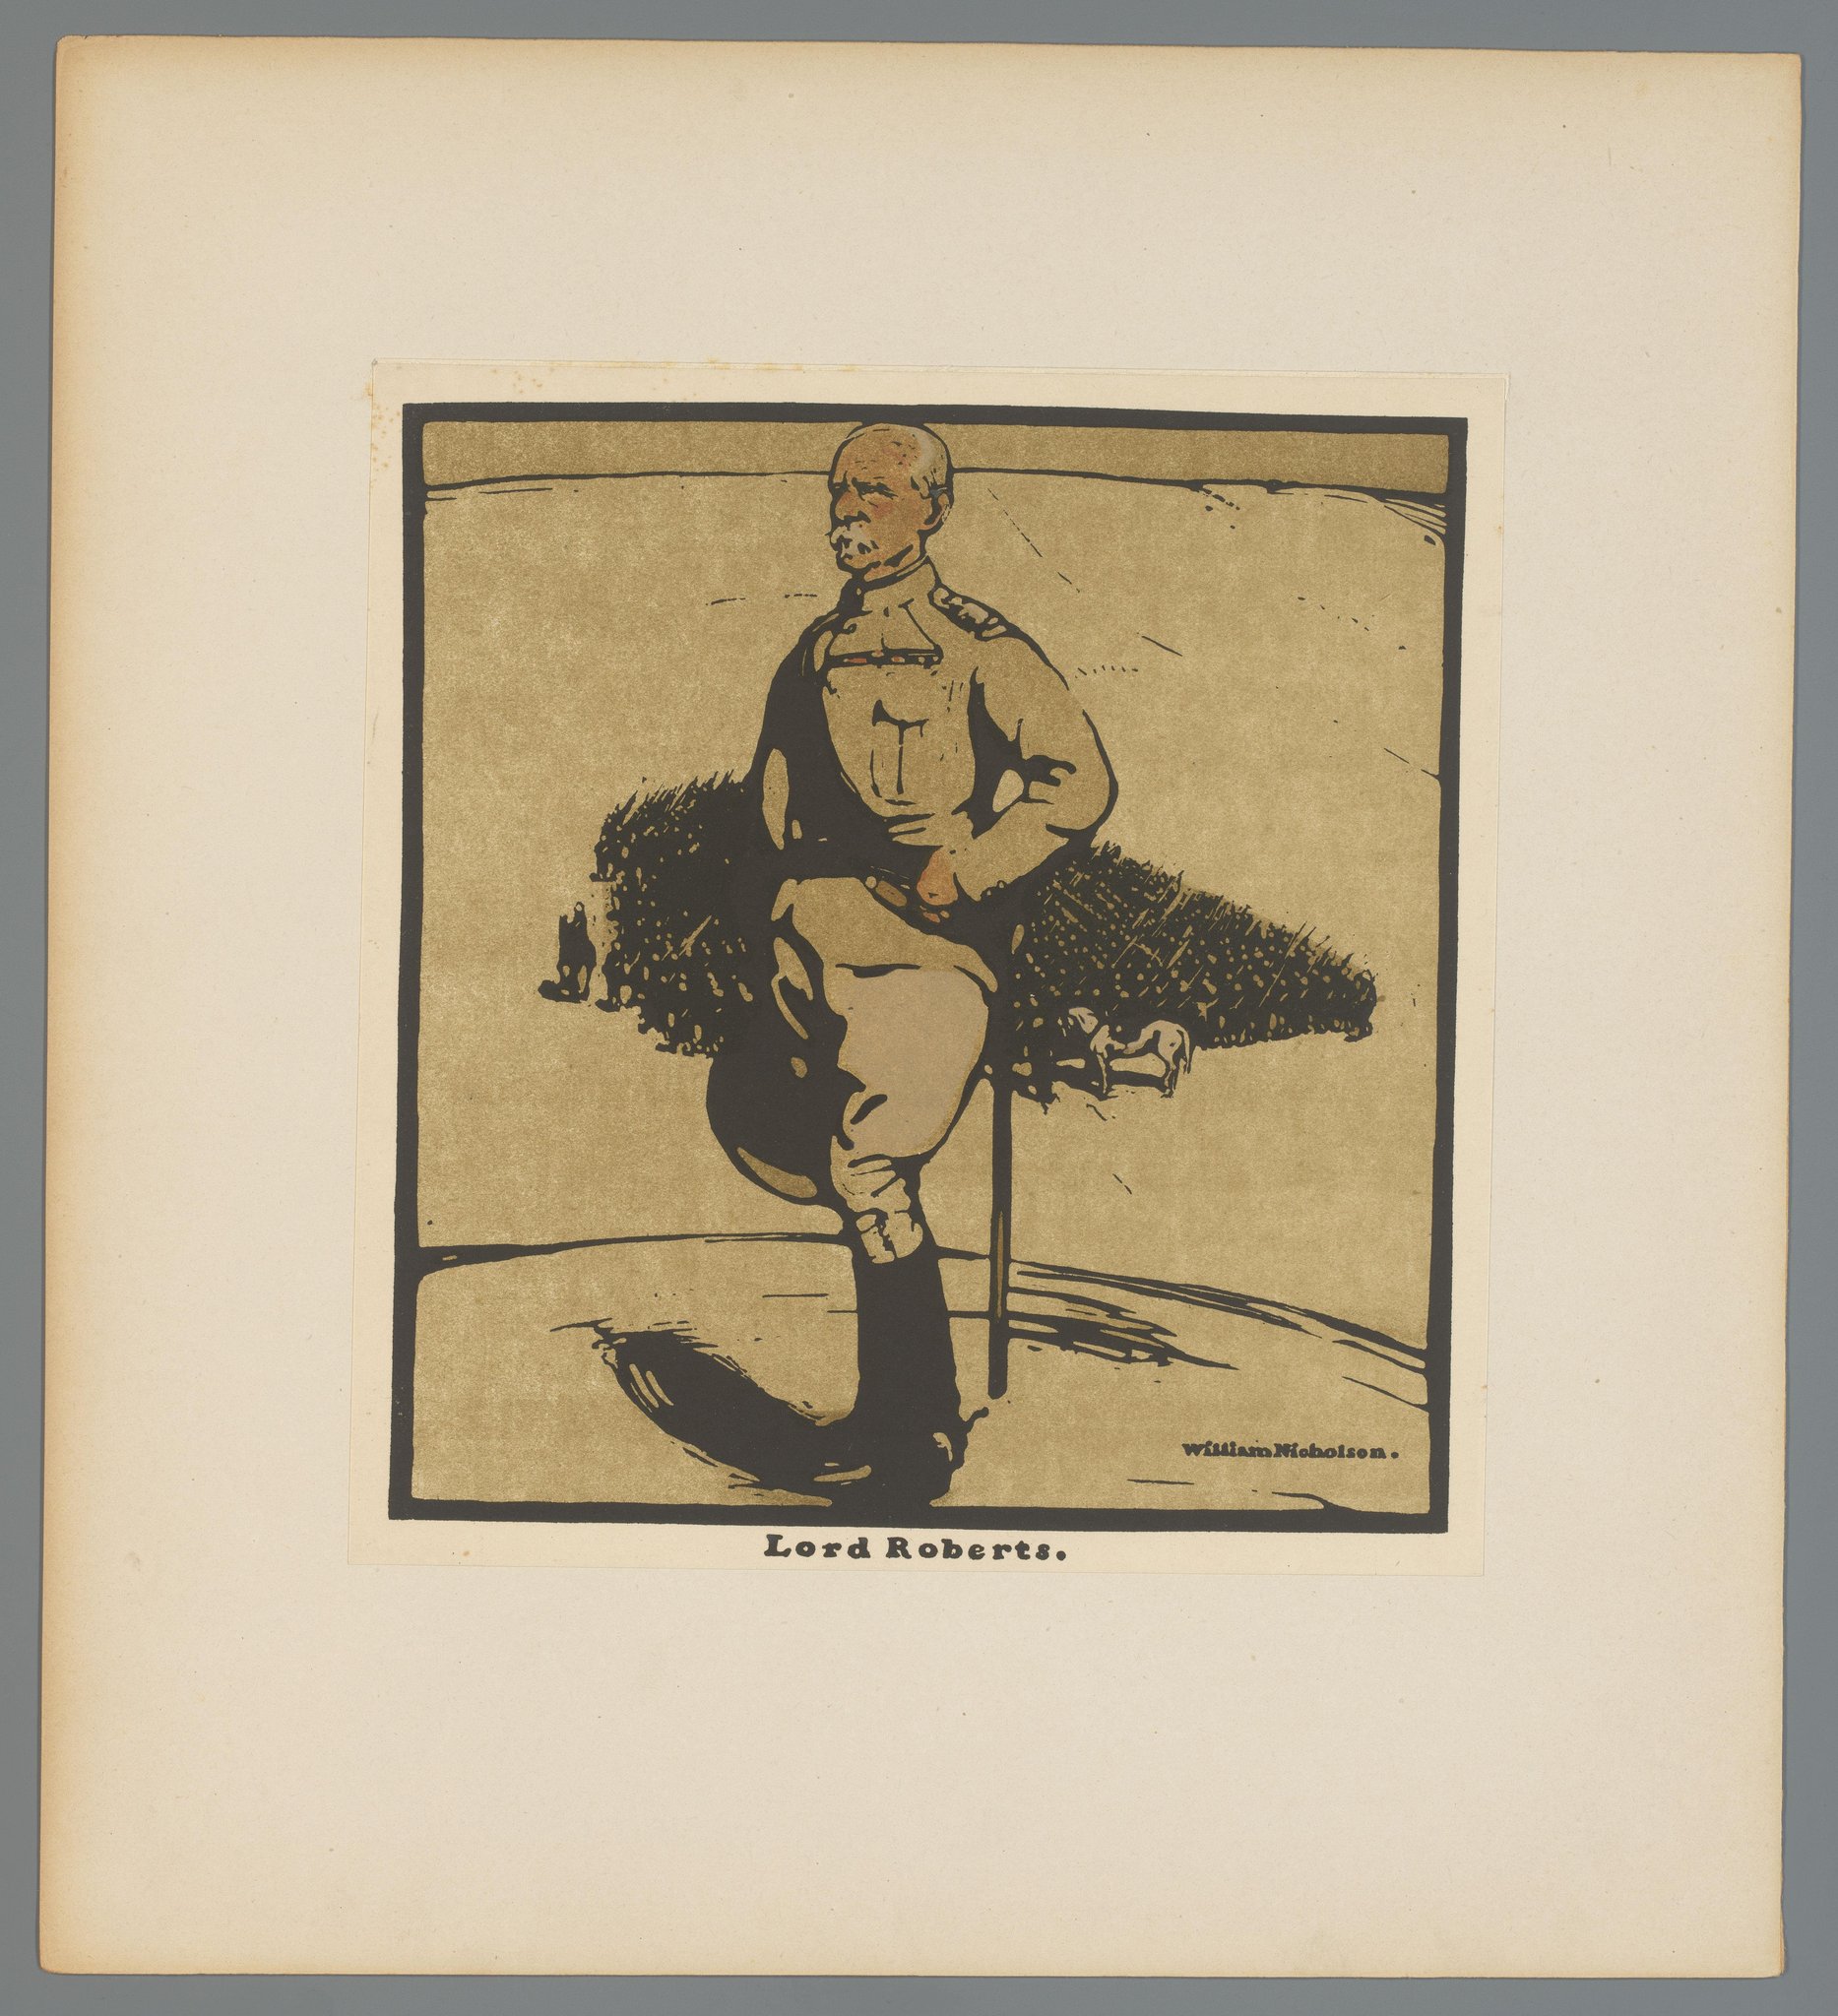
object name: print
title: Lord Roberts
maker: henri floury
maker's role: publisher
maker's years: 1862-1961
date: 1900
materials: paper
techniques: lithograph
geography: paris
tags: commander-in-chief, general, marshal, historical persons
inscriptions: collector's mark: Lugt 2228, collector's mark: Lugt 2760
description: De serie met lithografieën is gemaakt naar ontwerpen van houtsneden door William Nicholson.